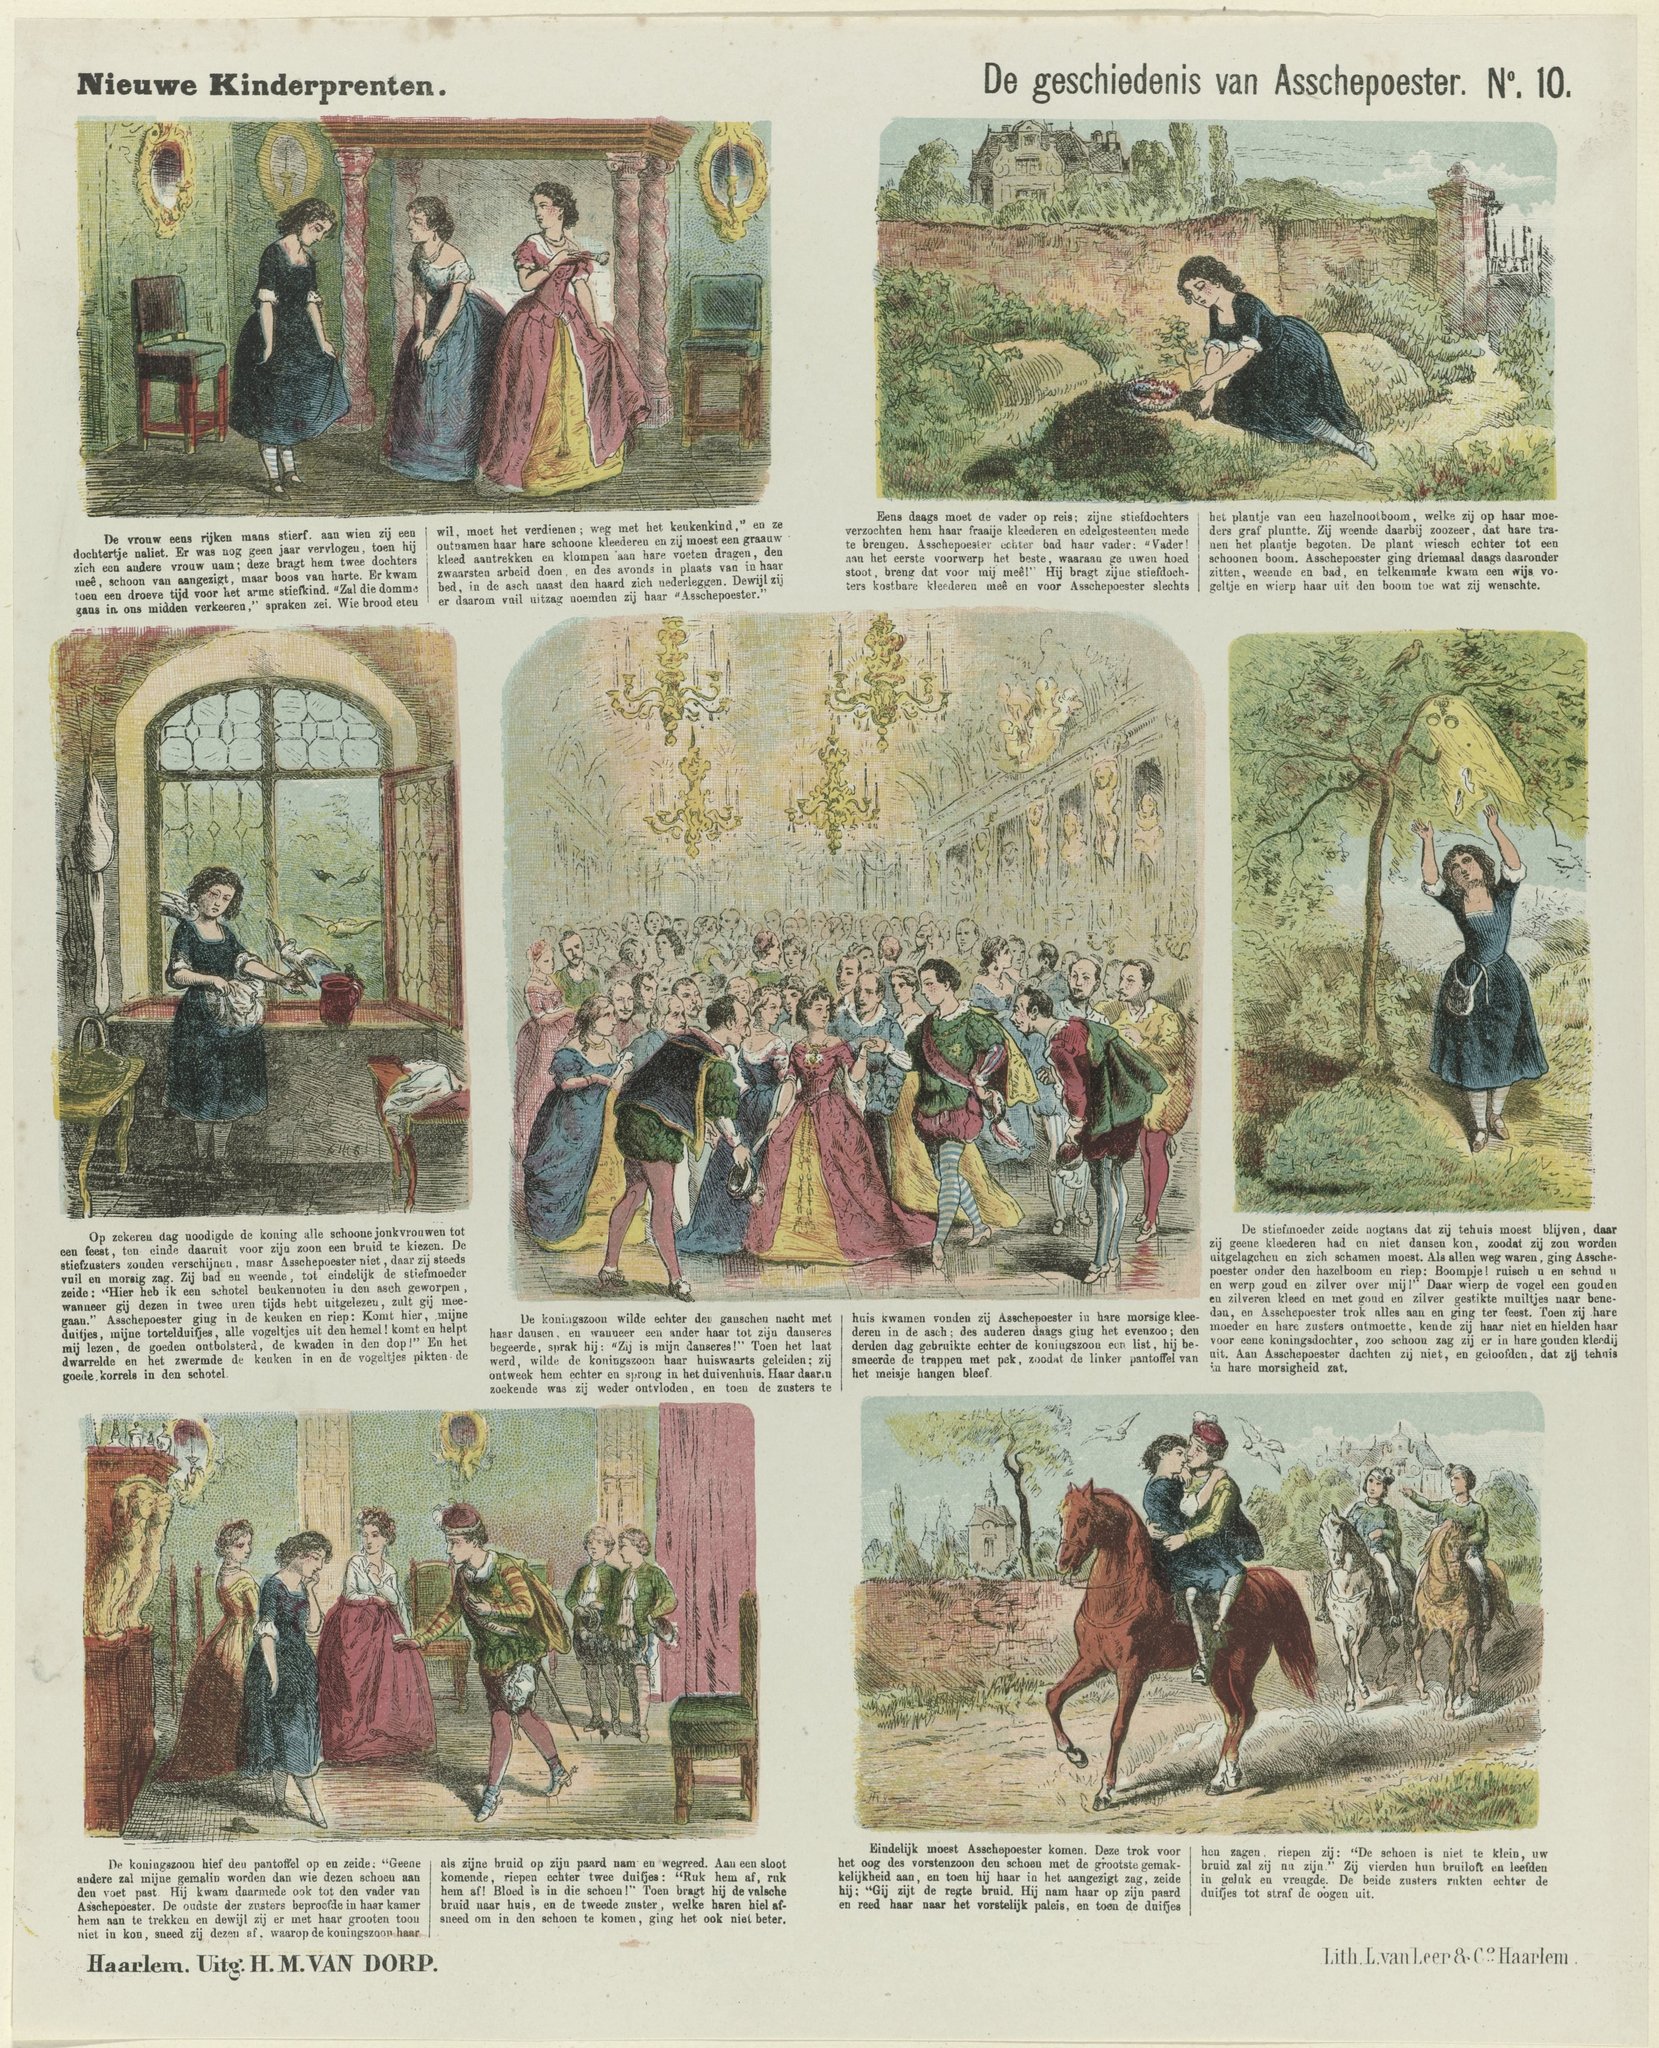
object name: popular print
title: De geschiedenis van Asschepoester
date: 1872-1883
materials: paper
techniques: lithograph, letterpress printing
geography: haarlem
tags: tales and fairy tales (with title)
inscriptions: collector's mark: Lugt 2760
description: Blad met 7 voorstellingen uit het sprookje van Assepoester. Onder elke voorstelling een onderschrift. Genummerd rechtsboven: No. 10.